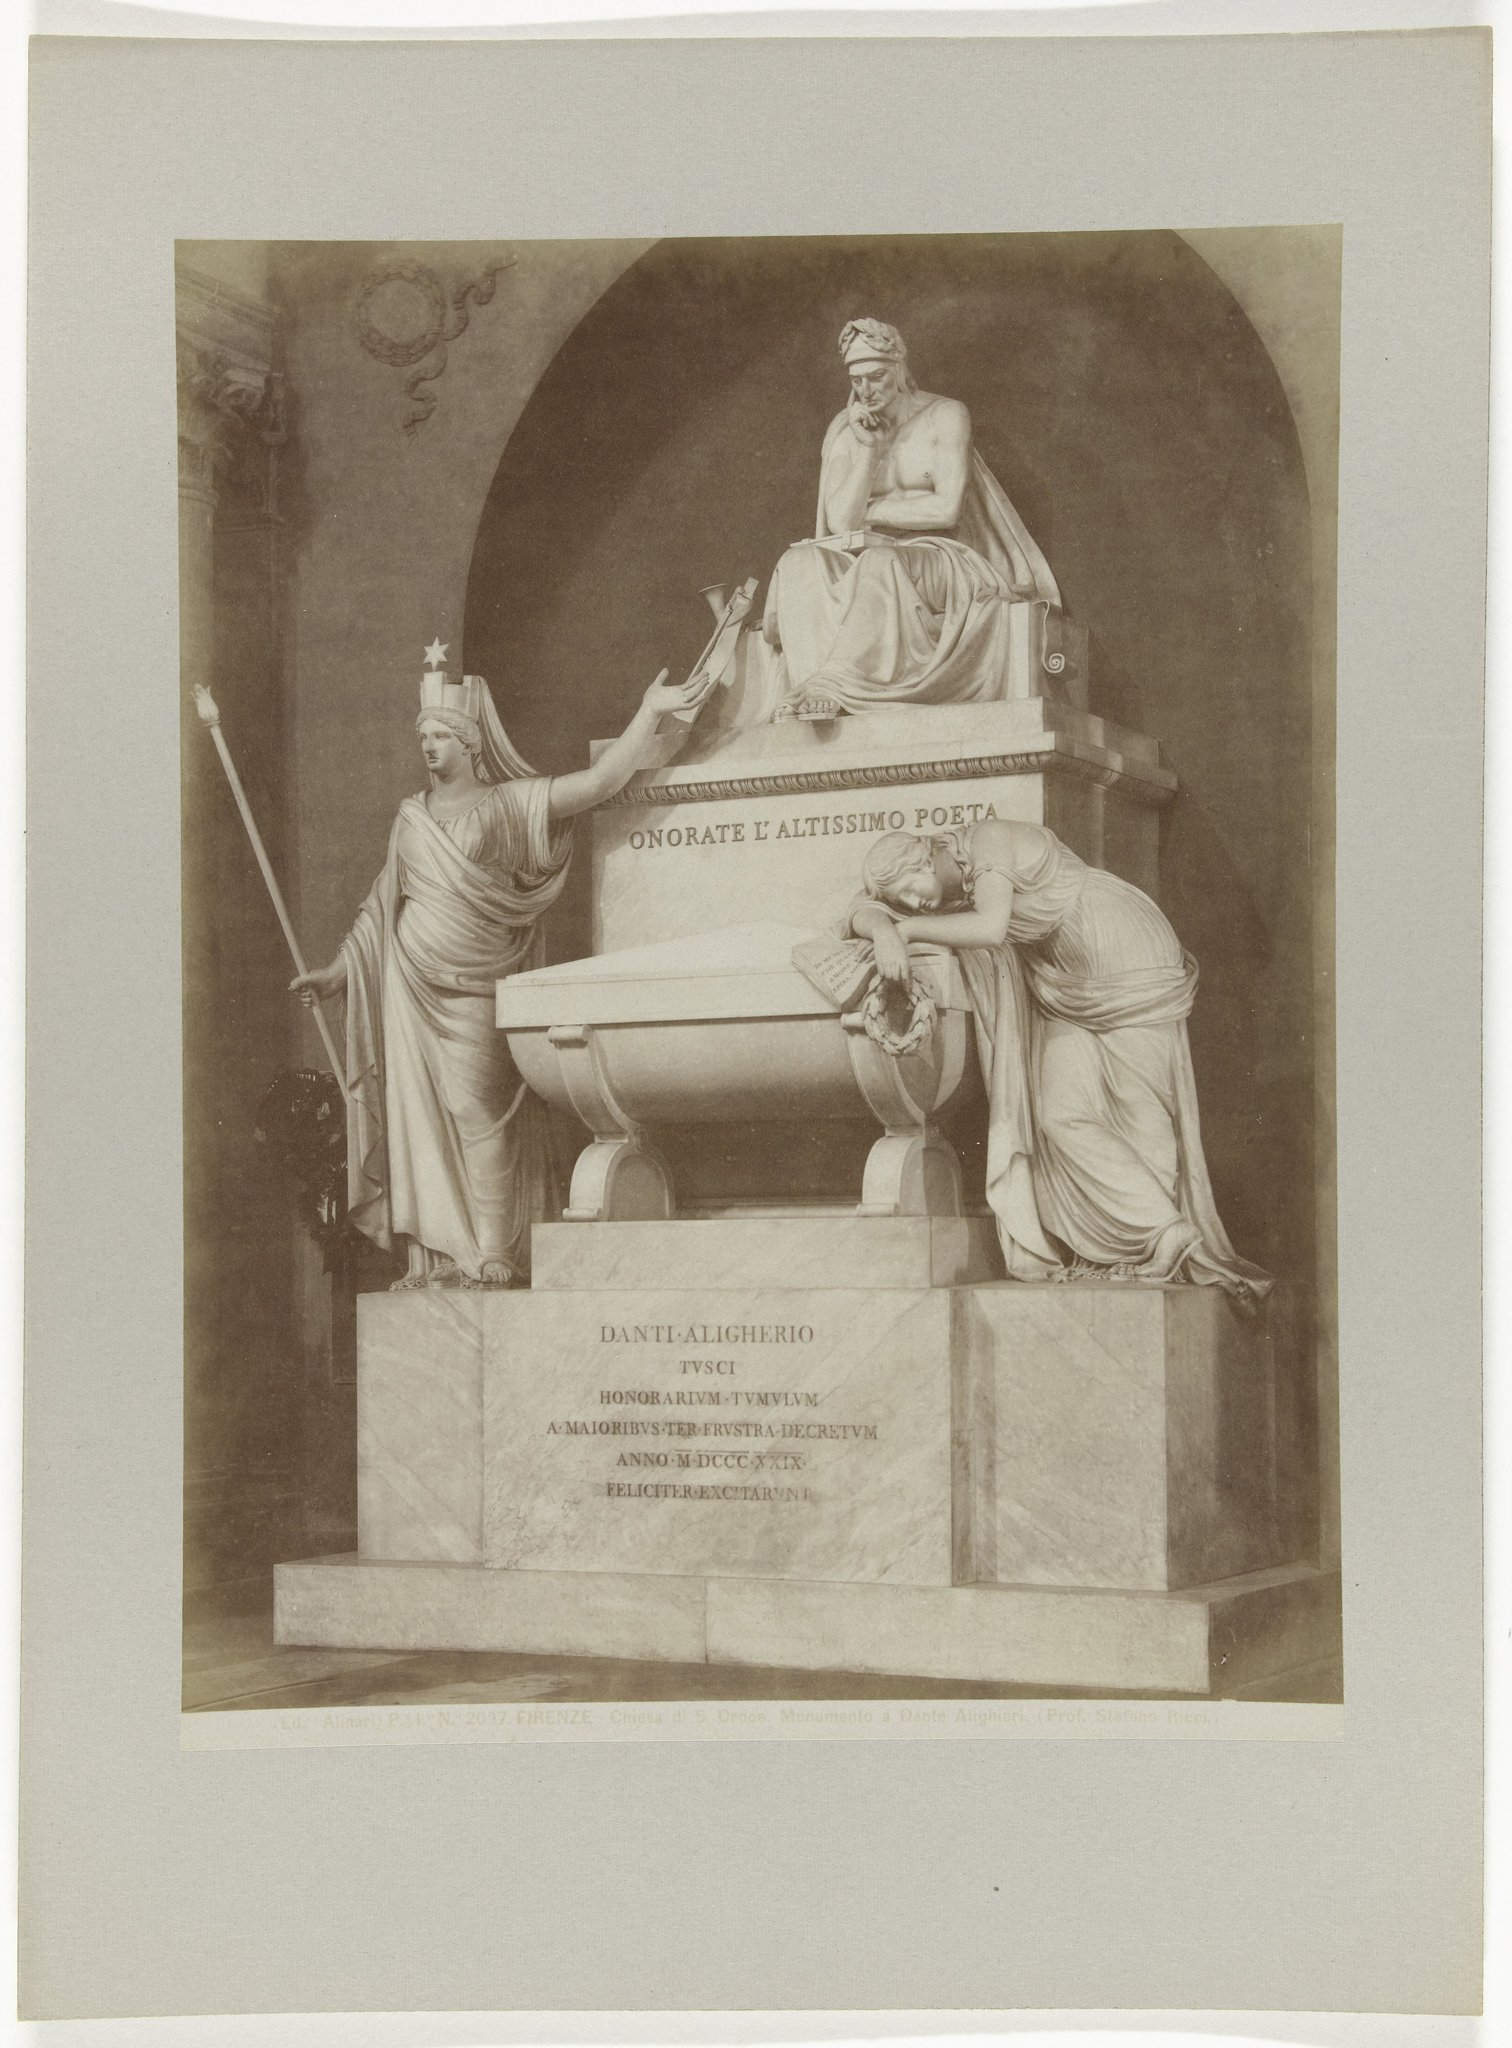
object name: photograph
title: Grafmonument van Dante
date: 1880-1895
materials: cardboard, paper, photographic support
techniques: albumen print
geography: florence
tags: dante alighieri, interior of church, piece of sculpture, reproduction of a piece of sculpture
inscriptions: number: ‘82.’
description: Monument met drie beelden in de Santa Croce te Florence.